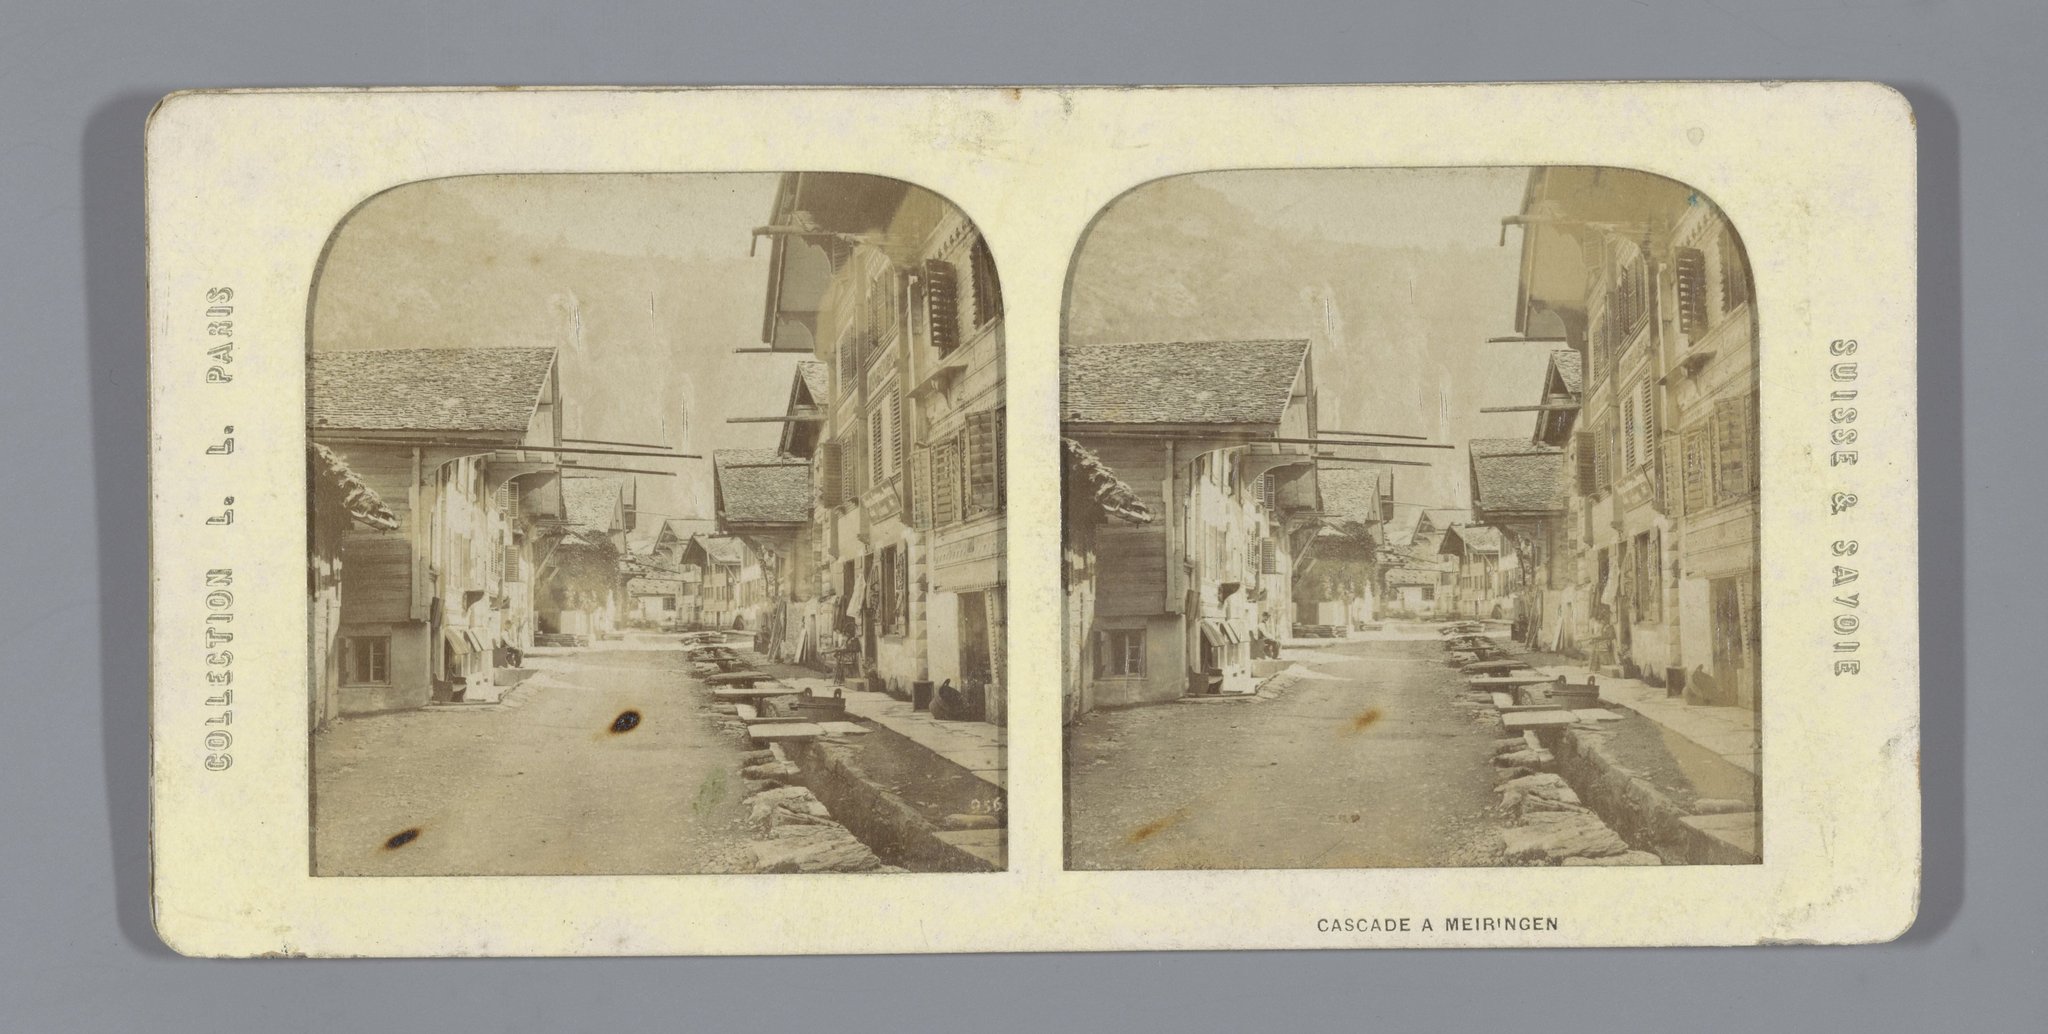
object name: tissue stereograph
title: Suisse et Savoie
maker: Anonymous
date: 1864-1875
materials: cardboard, paper, photographic support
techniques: albumen print, cutting, hand coloring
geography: meiringen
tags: waterfall, village, street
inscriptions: number: ‘956’